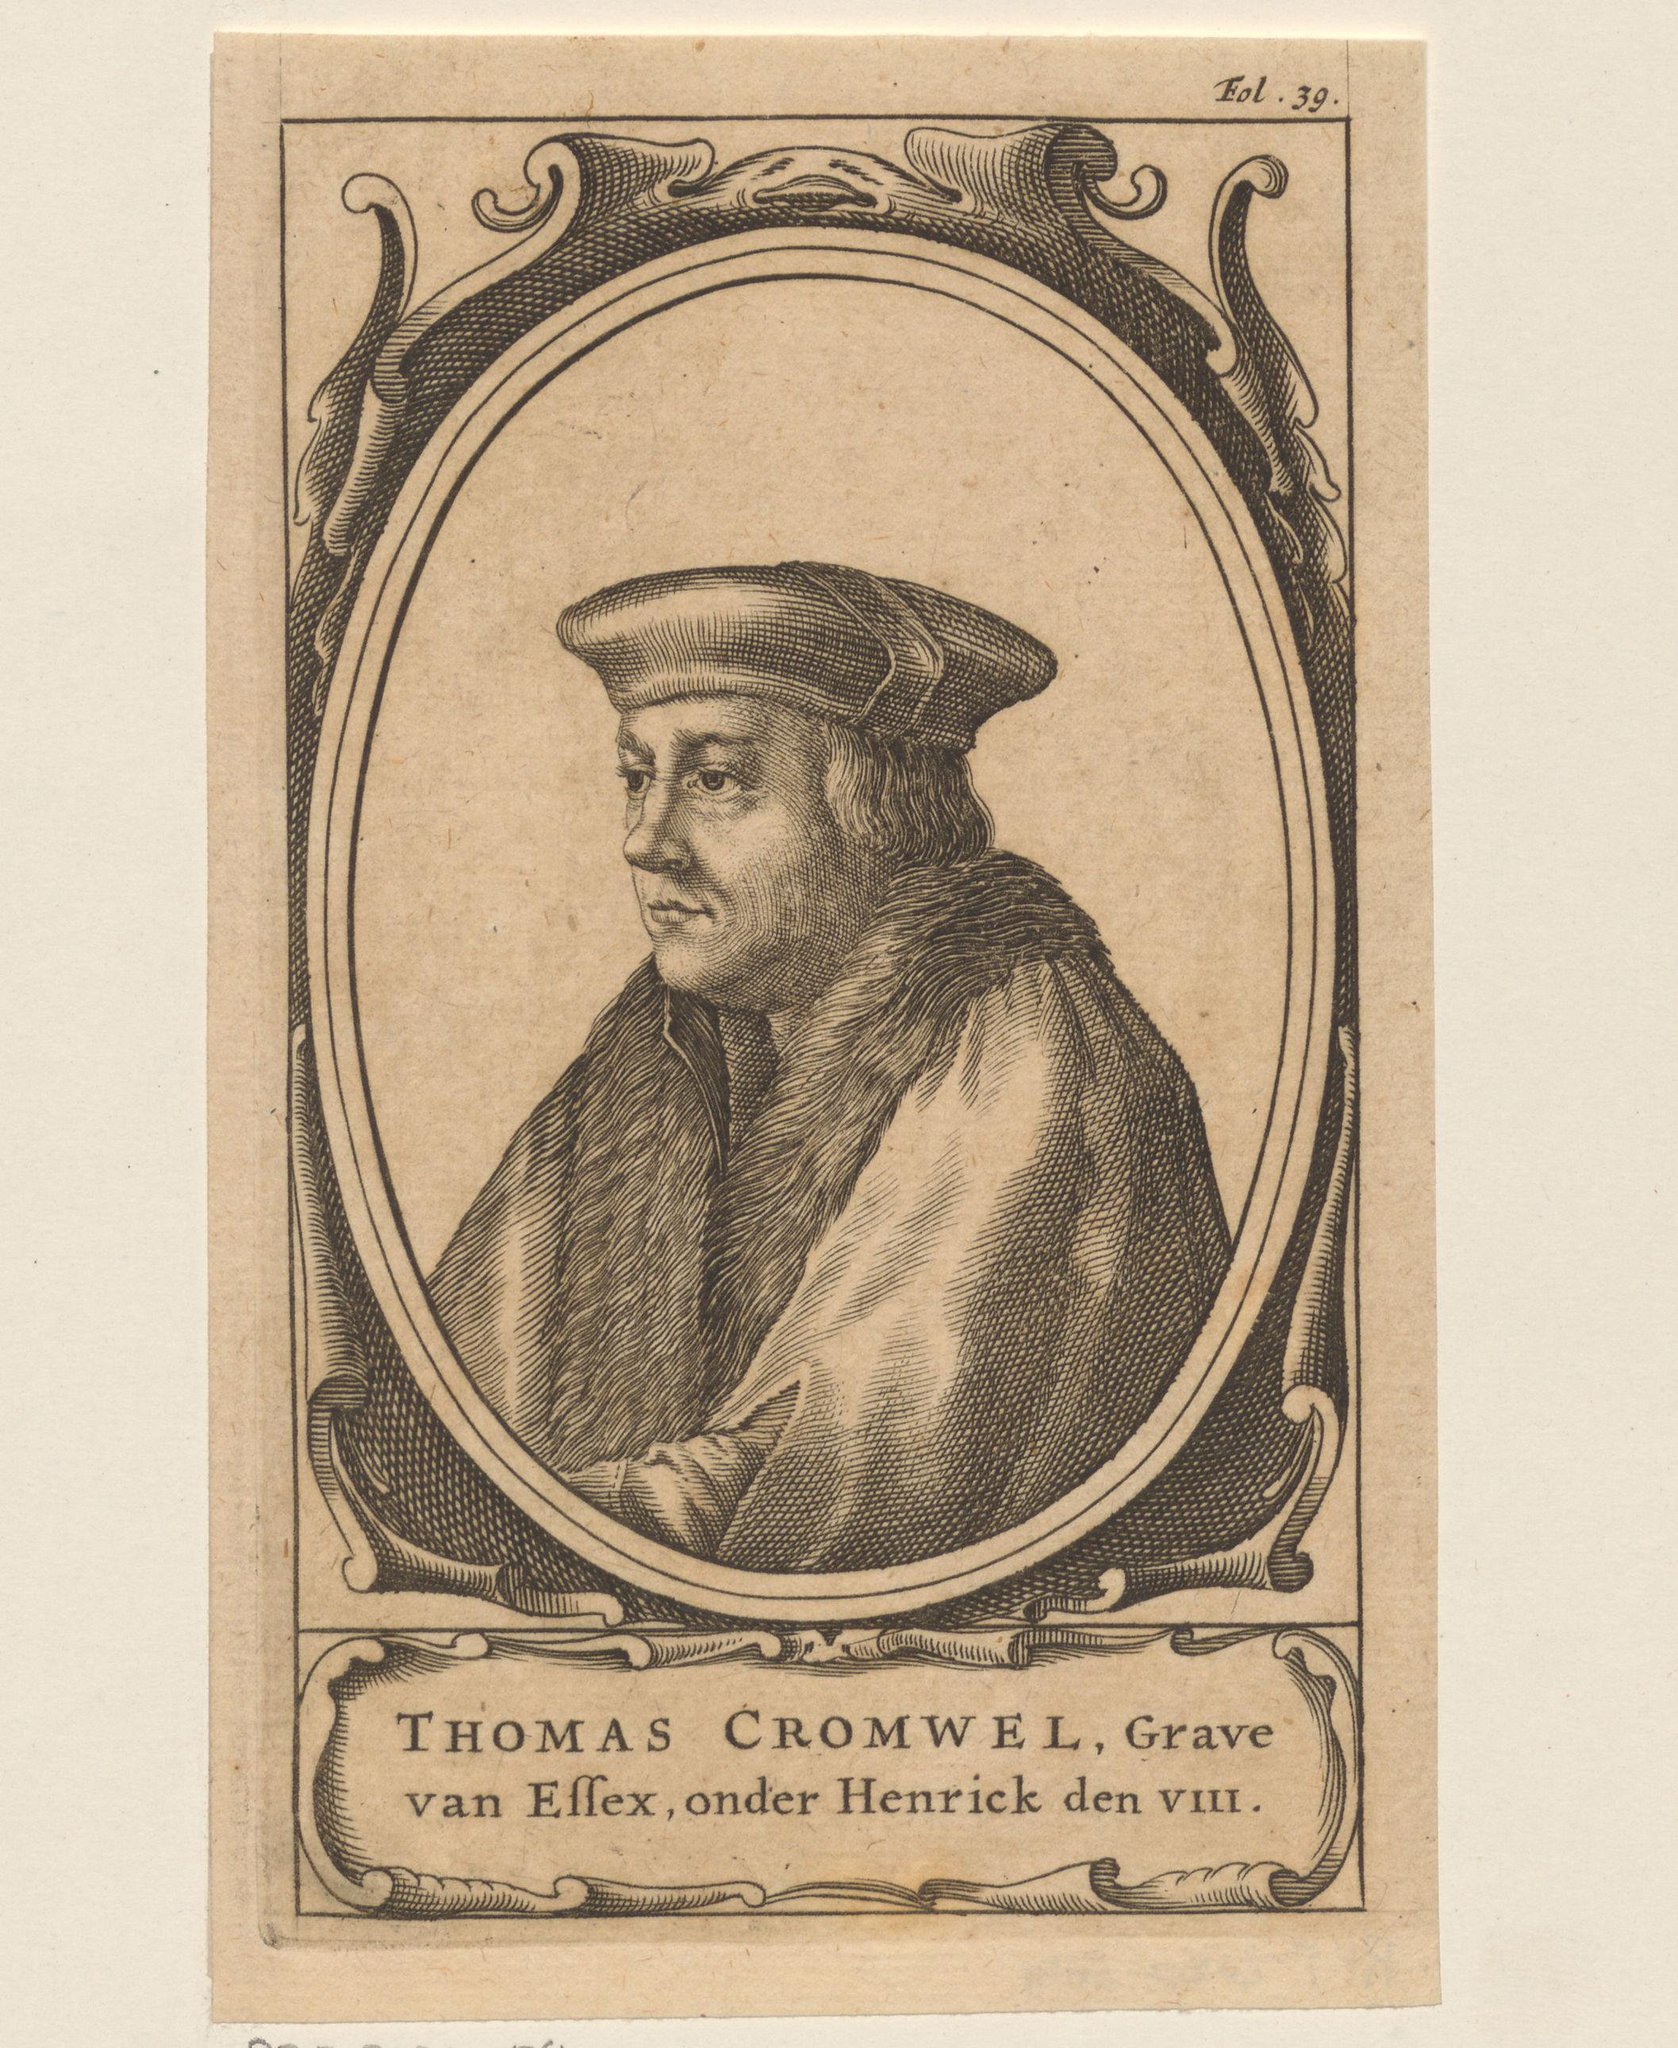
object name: print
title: Portret van Thomas Cromwell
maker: Anonymous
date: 1660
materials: paper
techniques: engraving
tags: historical persons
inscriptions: : Lugt 2228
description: Prent mogelijk uit: Corput, Abraham van den. De goddelicke vierschare, dat is ontdeckinge der hemelsche oordelen (…). Utrecht: Johannes Janssonius van Waesberge I, 1660, dl. 1. Prent ook gebruikt in latere edities van dit werk.